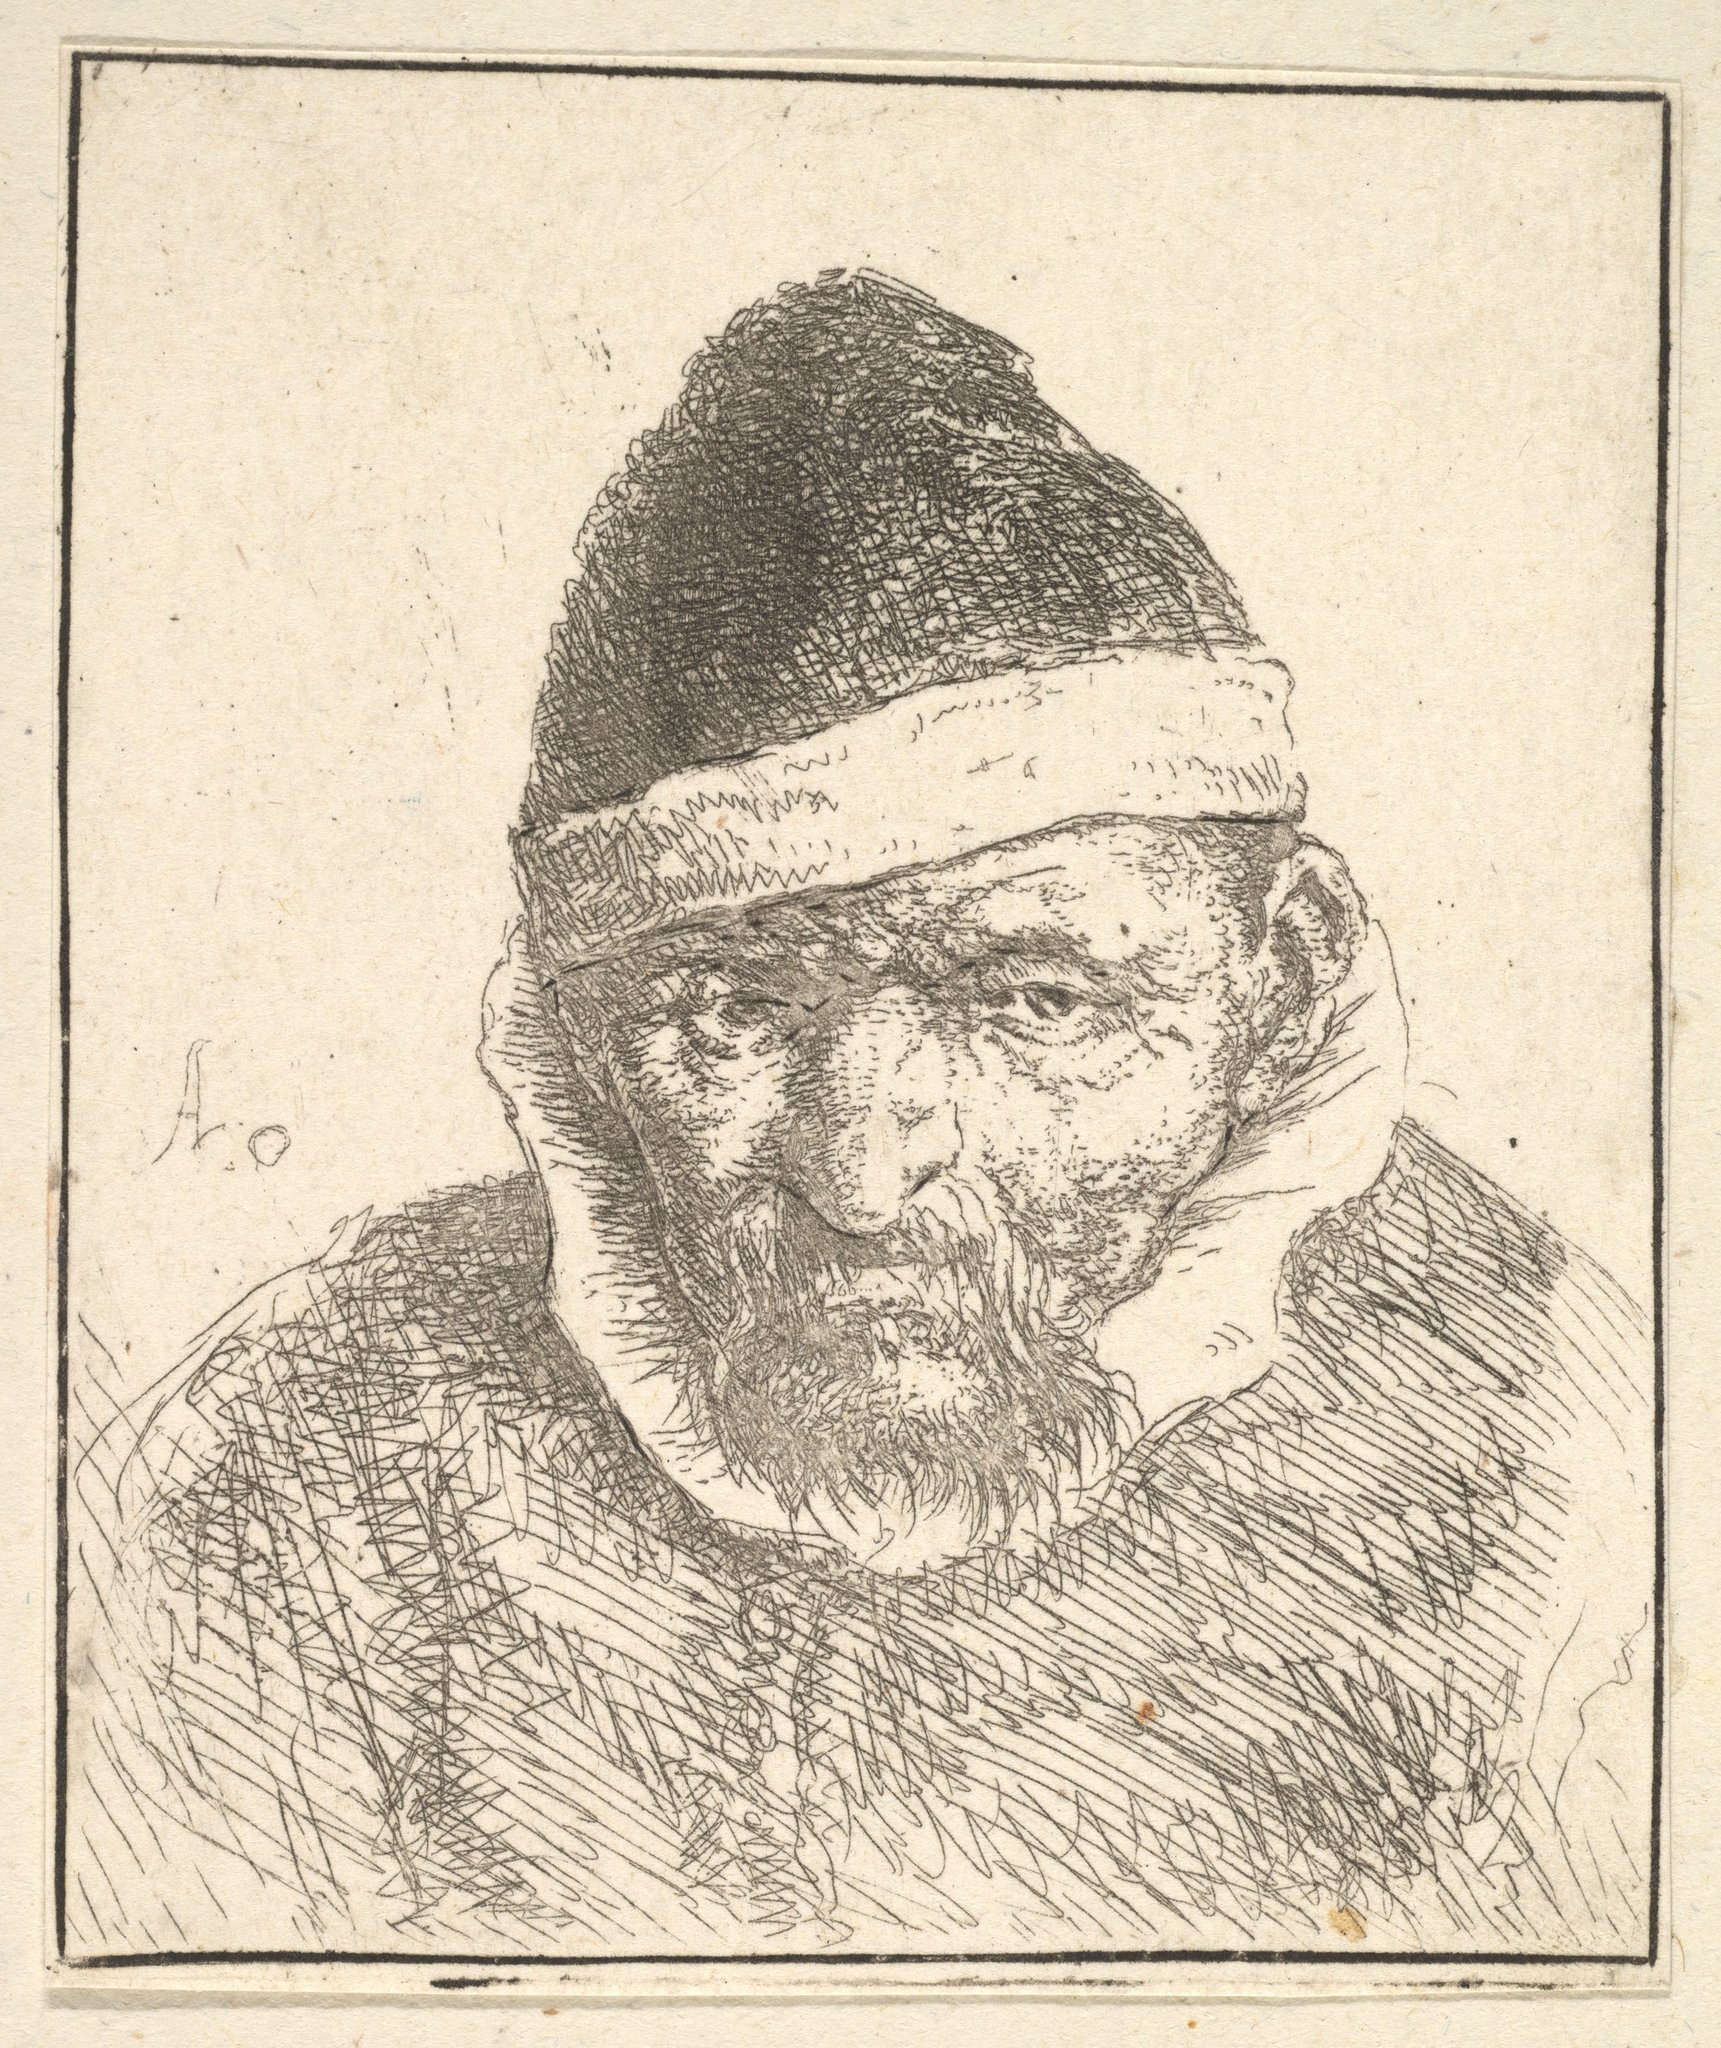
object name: print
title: Old Man with White Collar and Pointed Hat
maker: adriaen van ostade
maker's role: artist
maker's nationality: dutch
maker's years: 1610-1685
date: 1610-1685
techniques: etching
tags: men,portraits